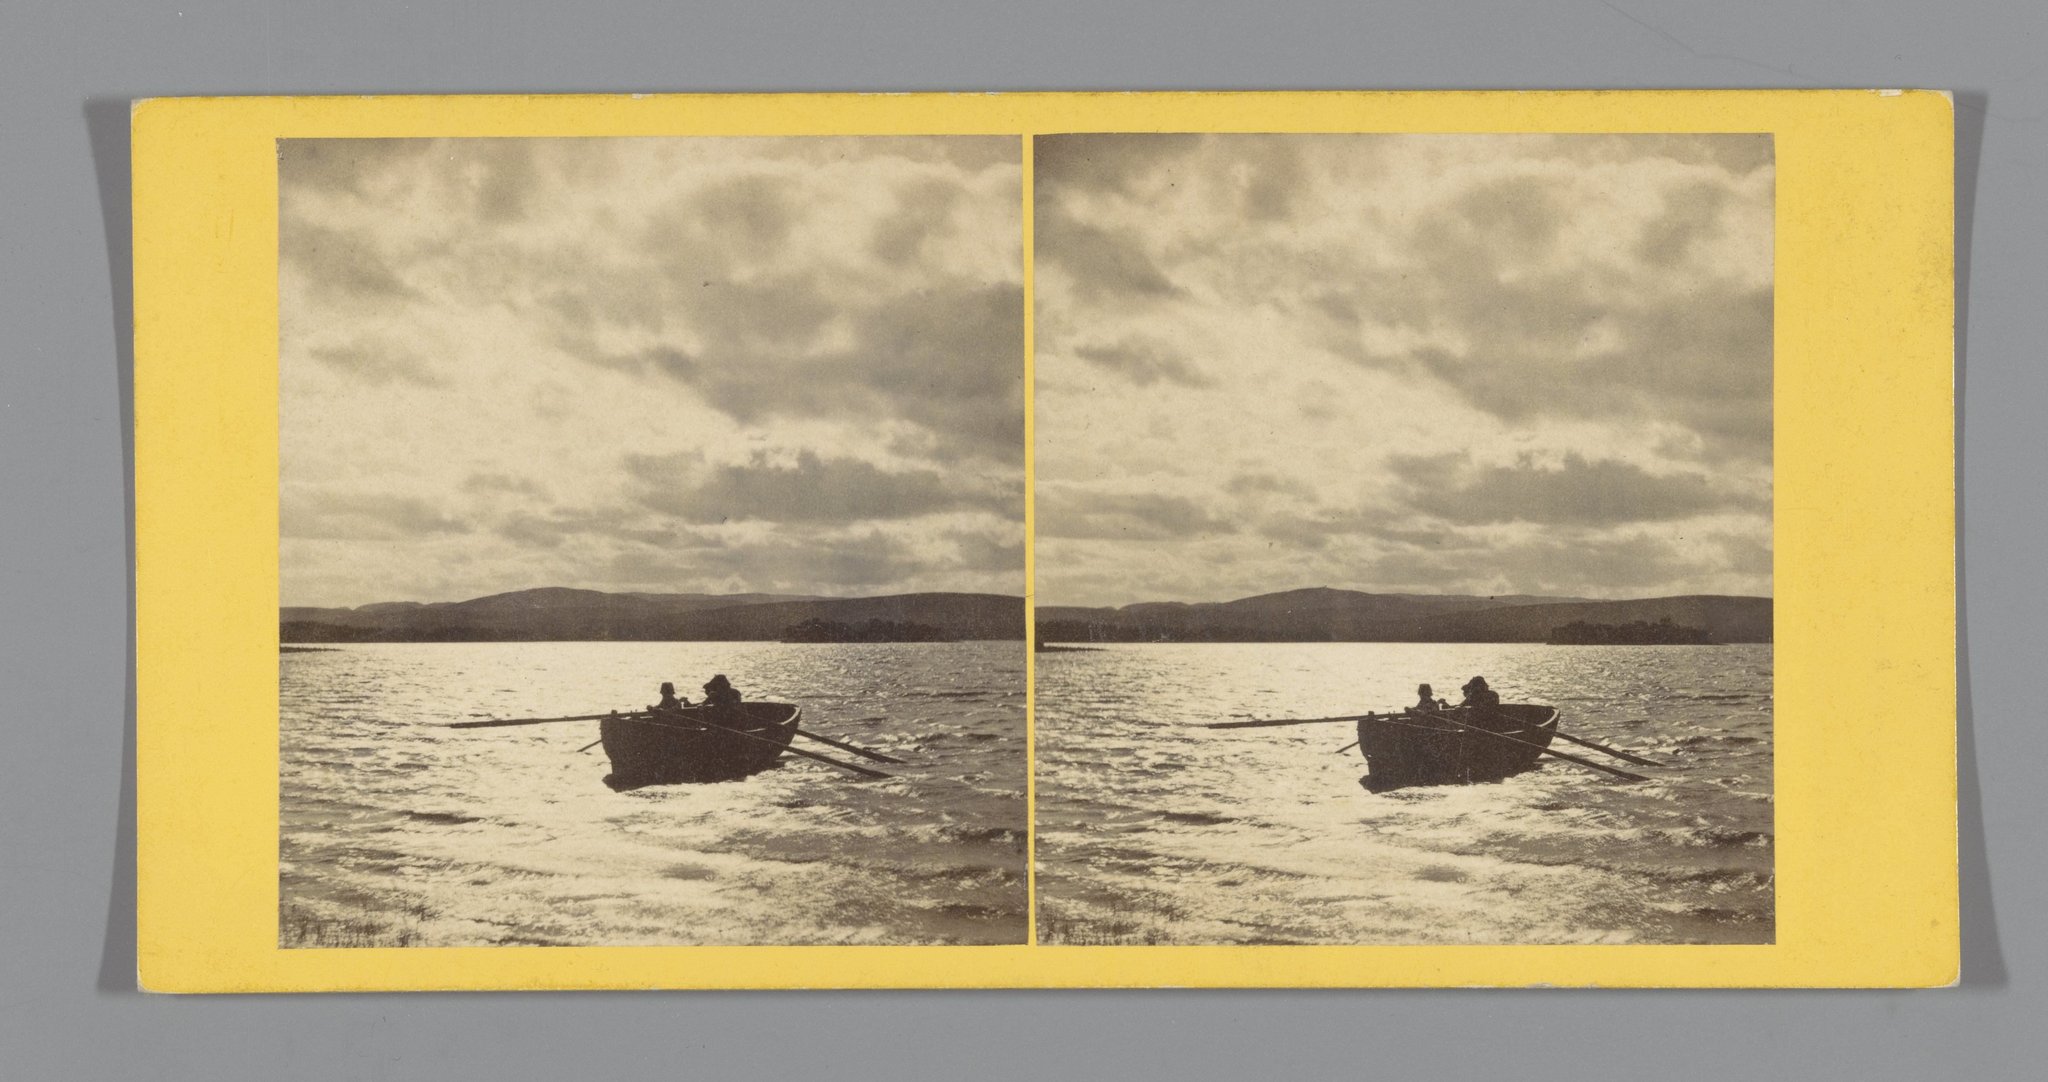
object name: stereograph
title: Loch-in-Dorb, Morayshire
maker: george washington wilson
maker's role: publisher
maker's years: 1823-1893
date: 1850-1880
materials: cardboard, photographic support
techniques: albumen print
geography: lochindorb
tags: rowing-boat, canoe, etc., lake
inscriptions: name: ‘G. W. Wilson, Photographer, Aberdeen.’, number: ‘No. 343.’